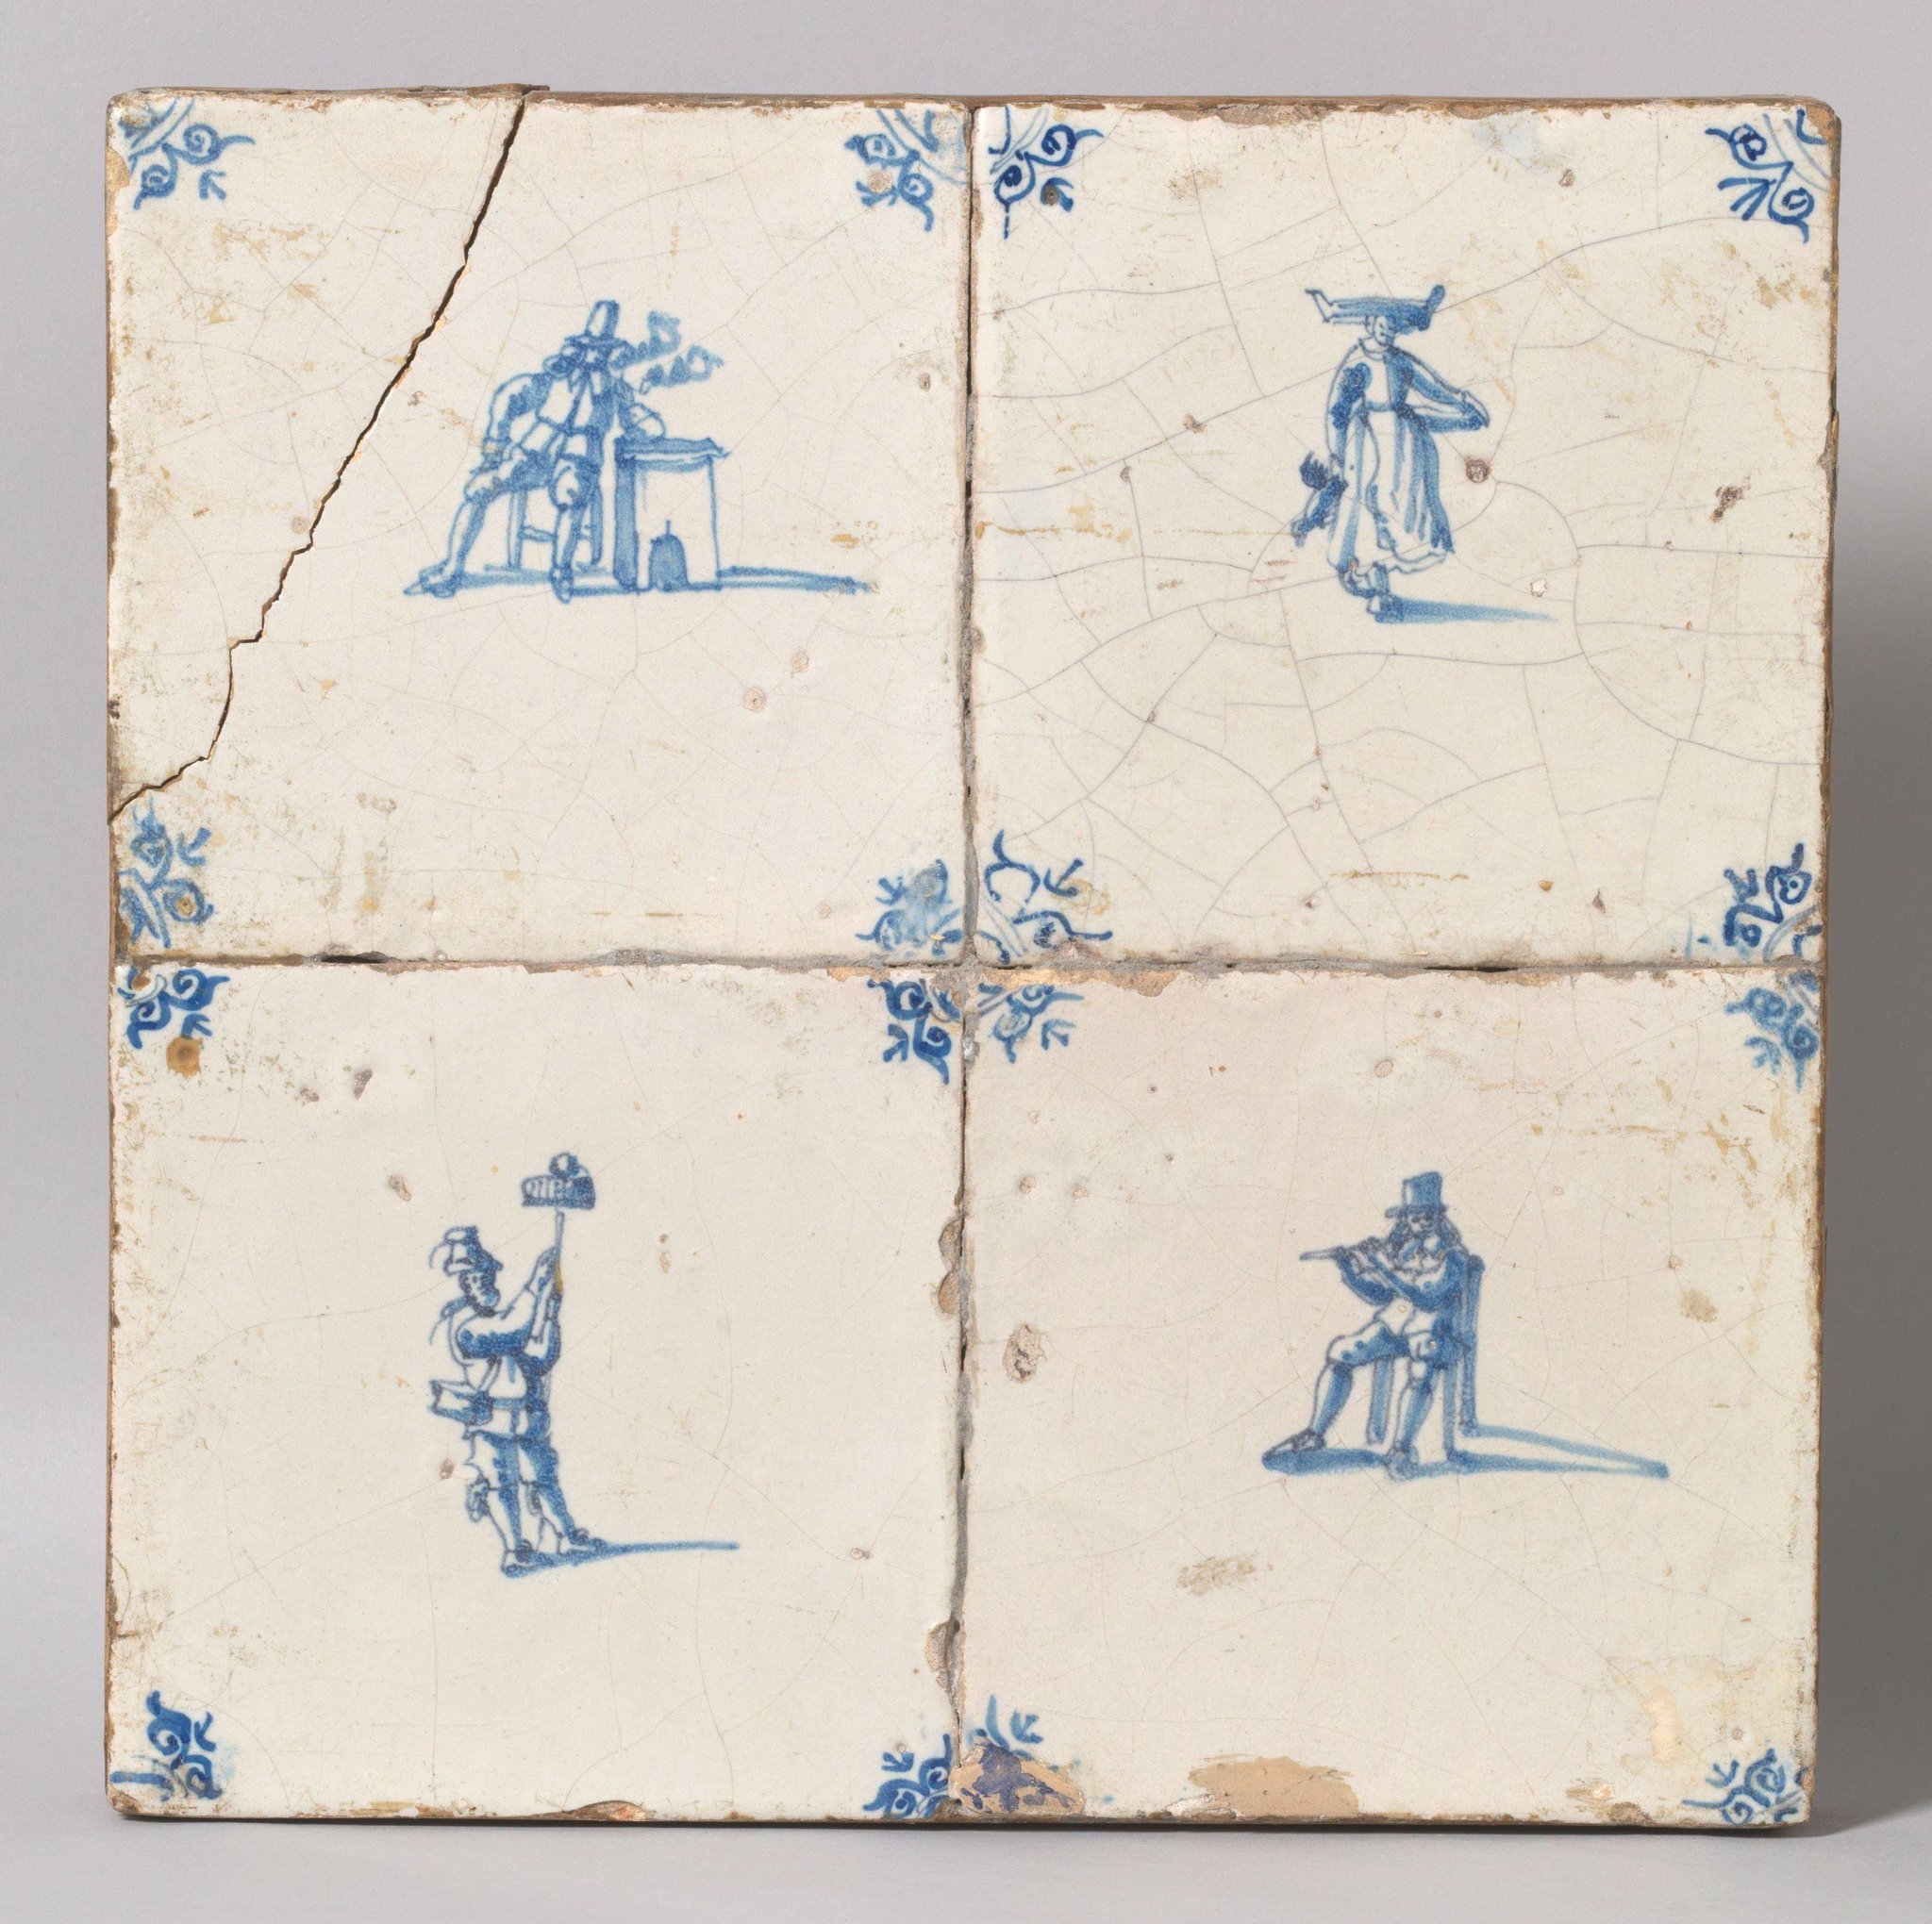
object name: tile tableau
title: Veld van vier tegels met mensen en hun ambachten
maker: Anonymous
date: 1625-1650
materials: earthenware, glaze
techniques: maiolica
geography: netherlands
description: Veld van 4 tegels (2 x 2) elk met een paars geschilderde figuur met zijn ambacht en beroep. In de hoeken, een ossekop.